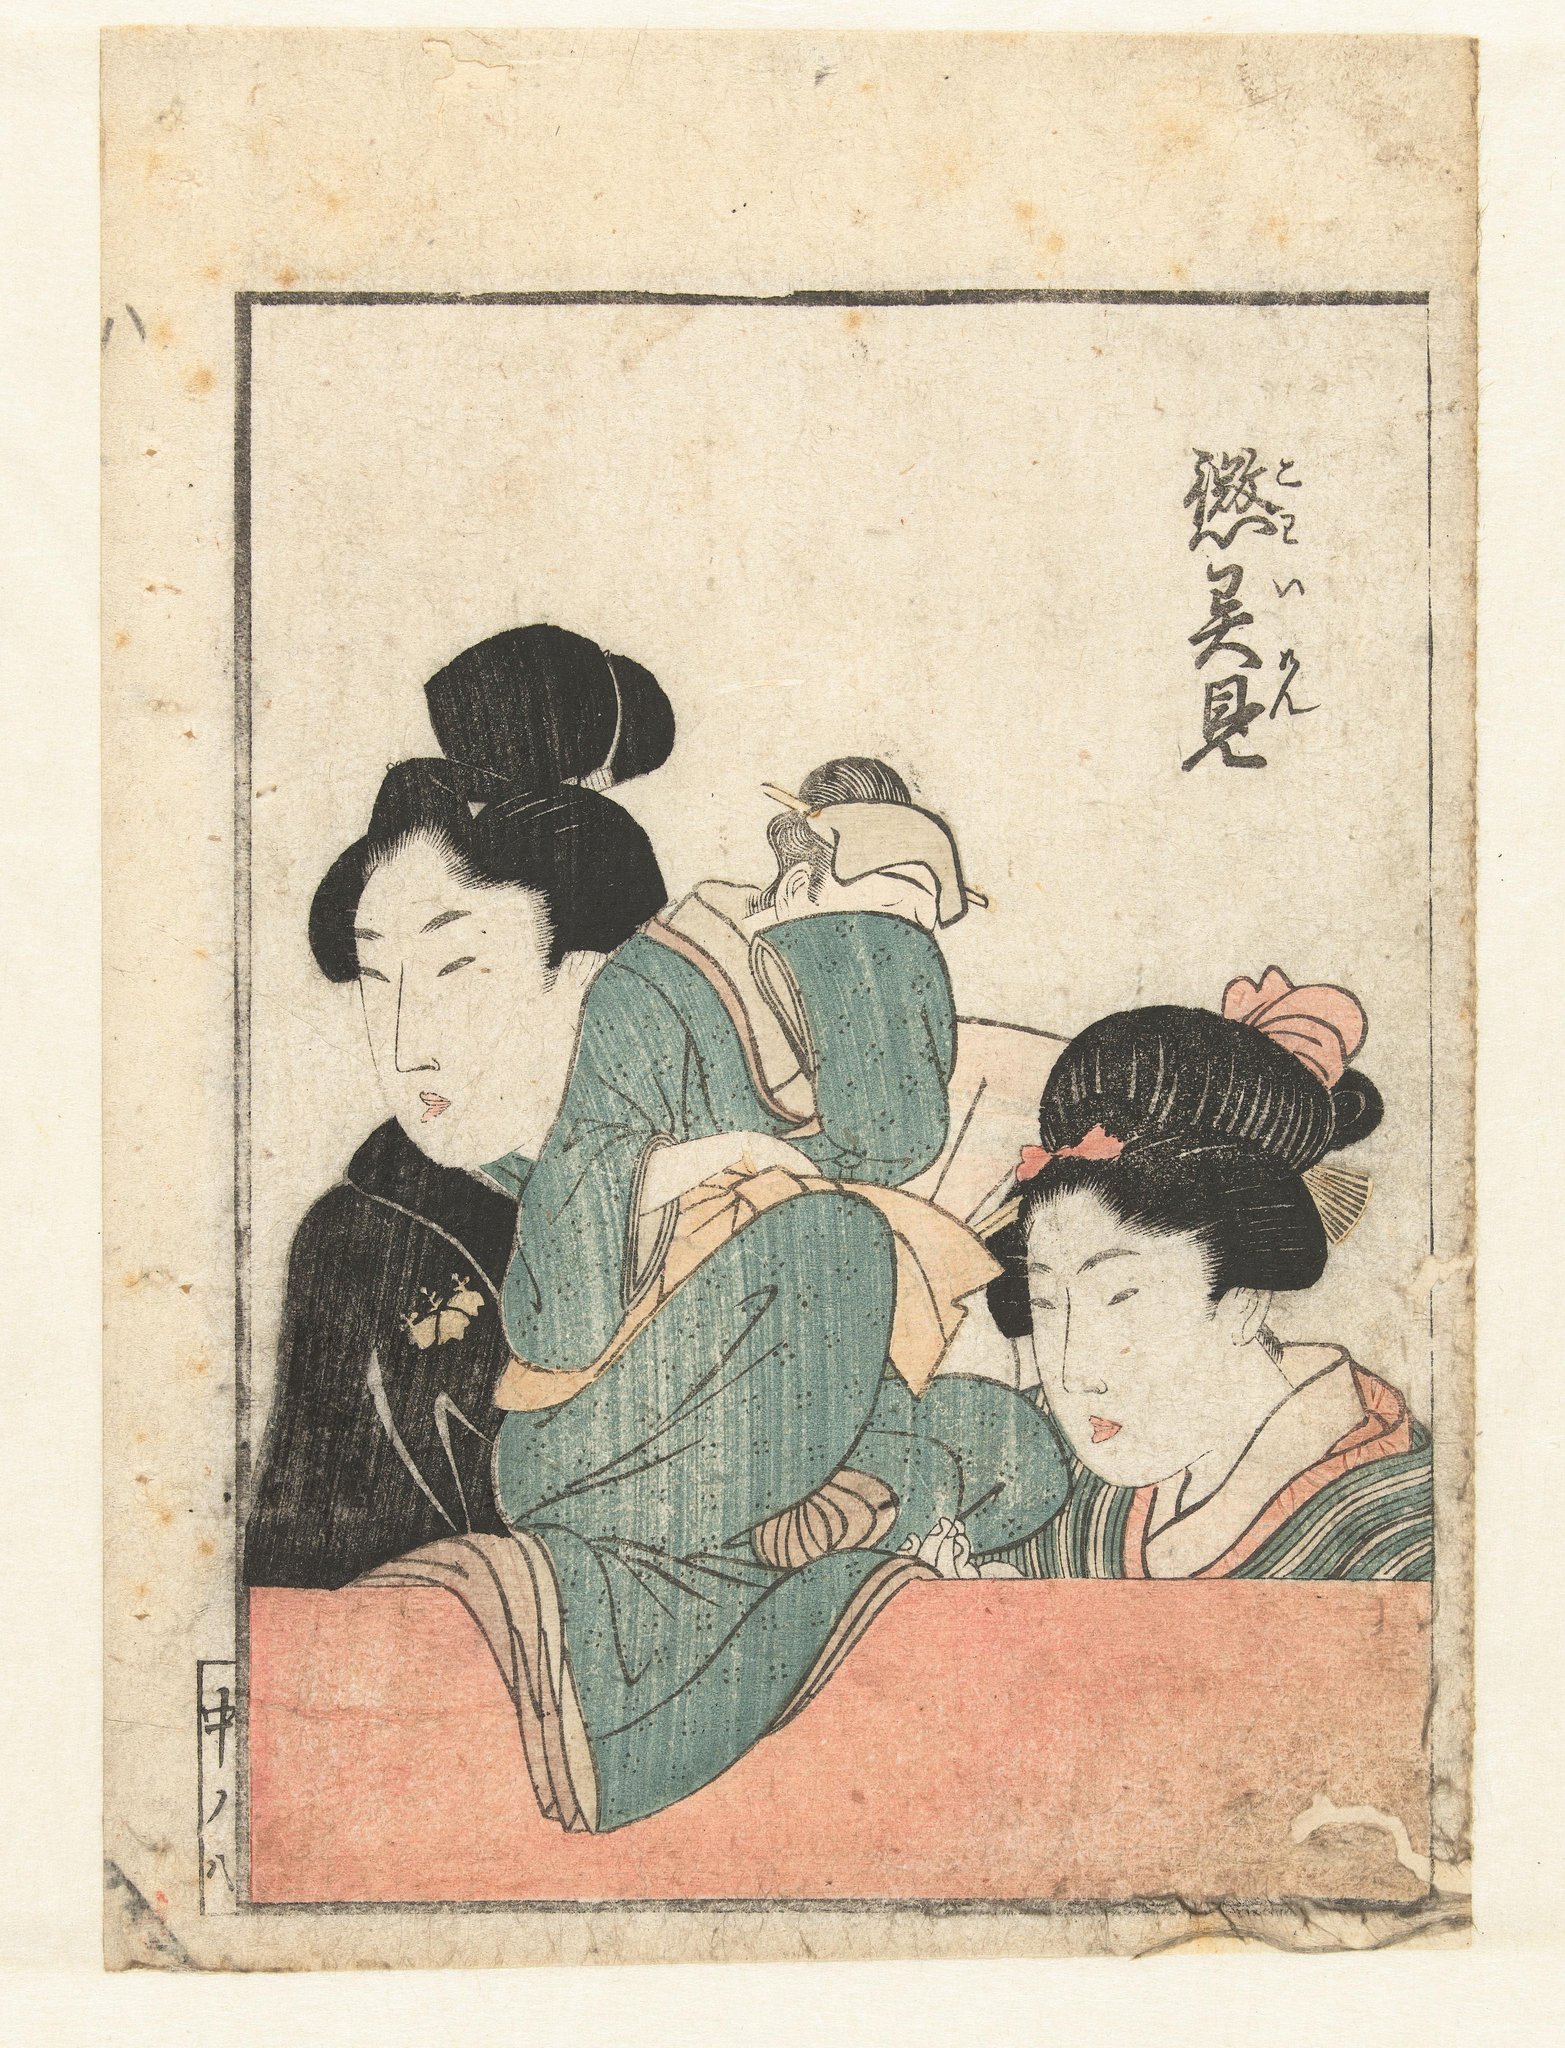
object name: print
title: Twee vrouwen met een pop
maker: katsushika hokusai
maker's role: draughtsman, print maker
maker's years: 1760-1849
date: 1775-1876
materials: paper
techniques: woodcut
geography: japan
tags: dolls for adults, (playing with) dolls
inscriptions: collector's mark: Lugt 2228